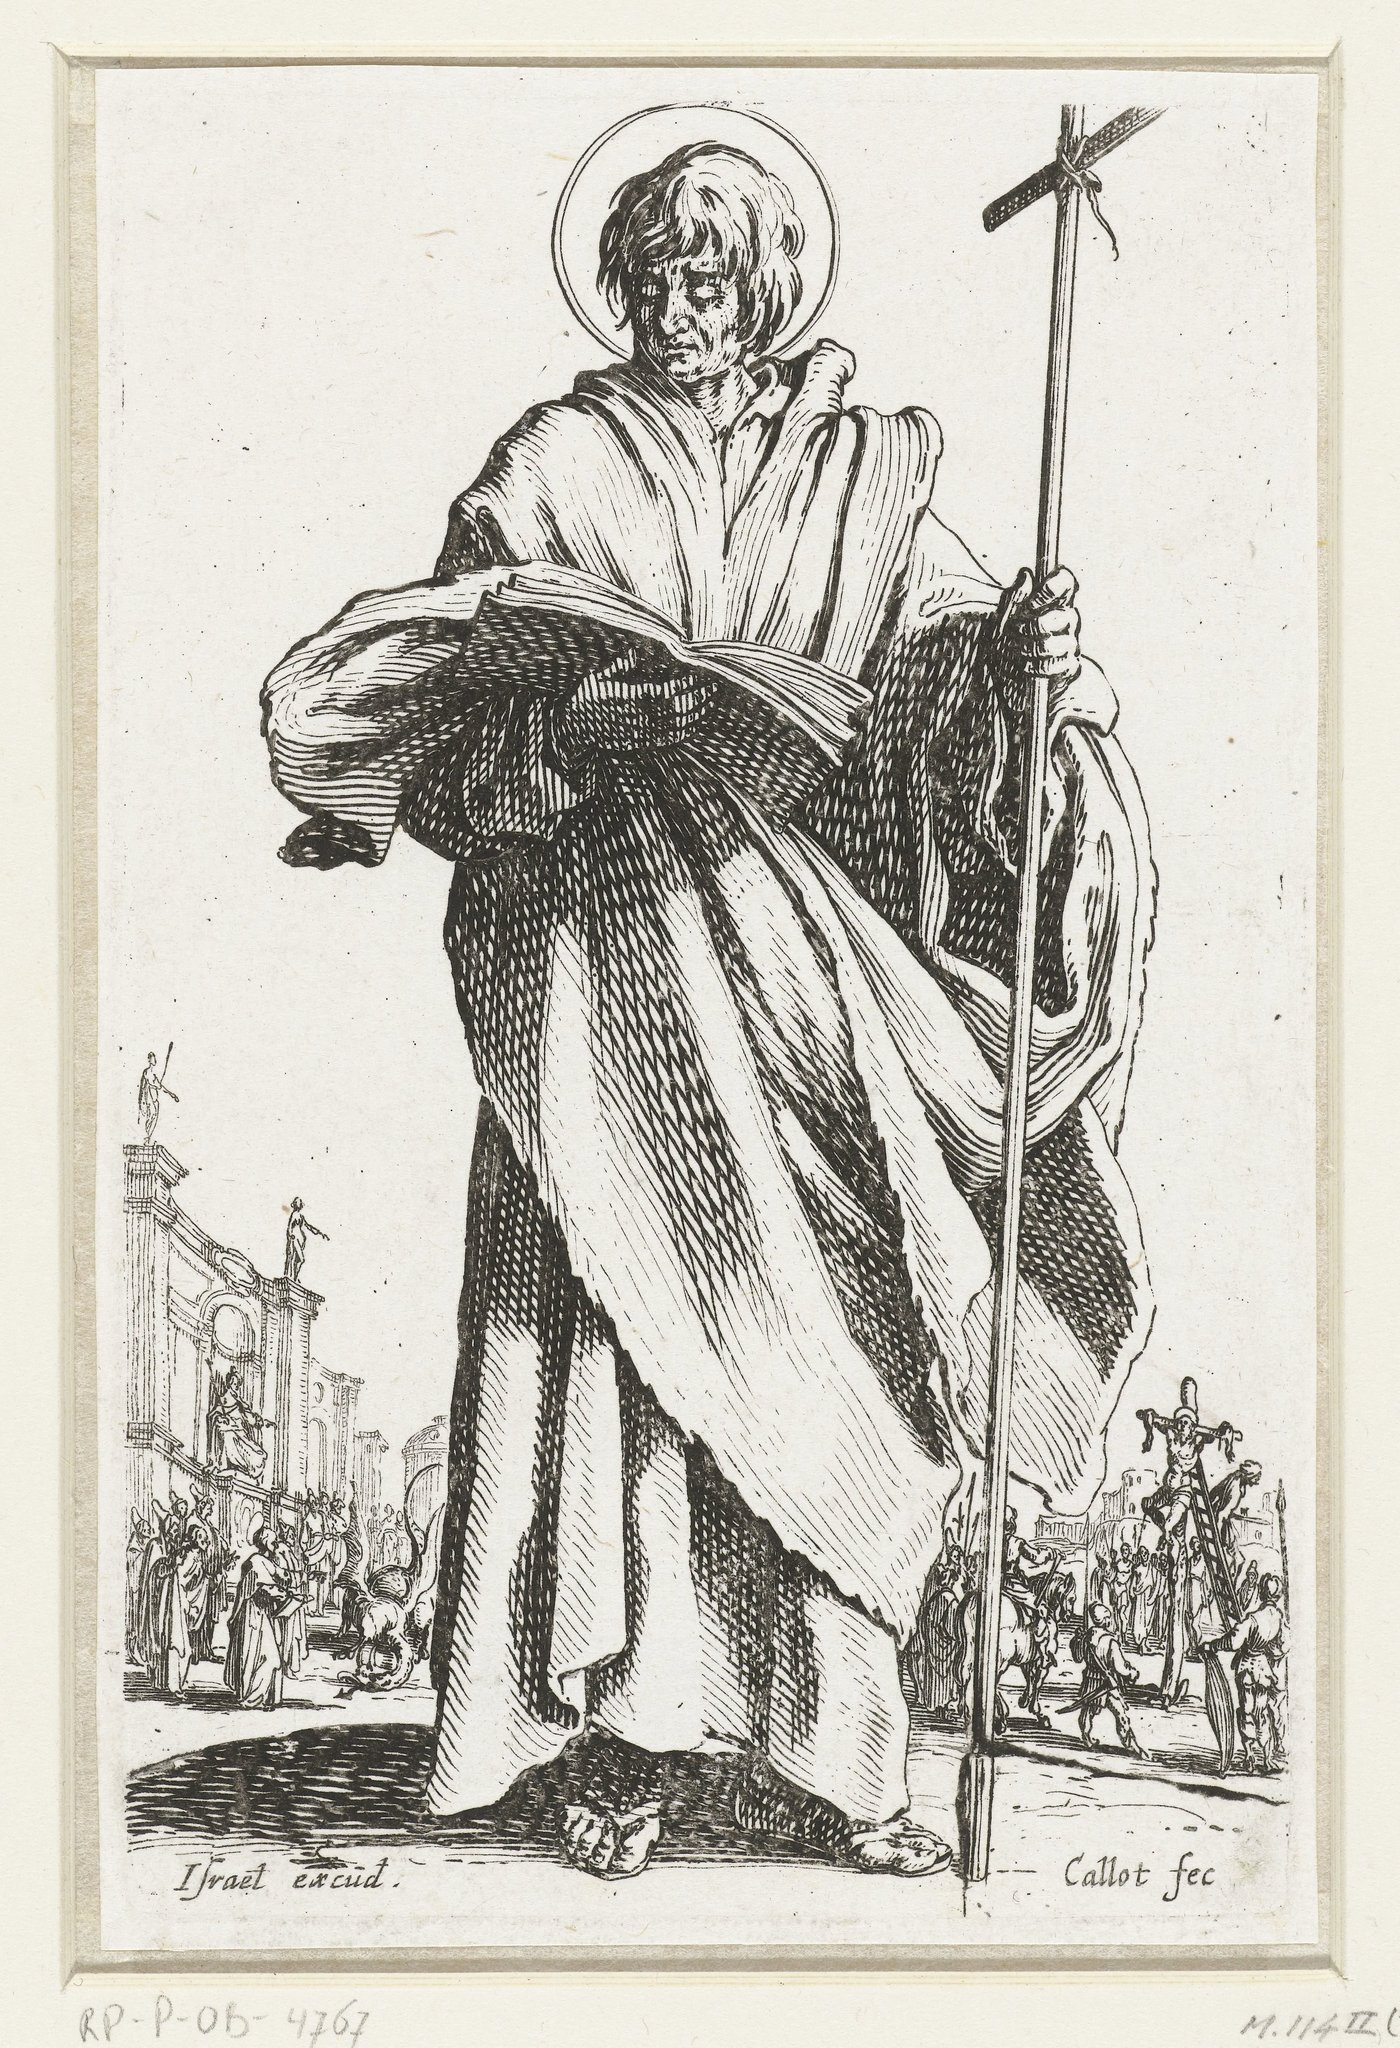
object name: print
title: De grote apostelen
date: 1631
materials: paper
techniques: etching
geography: nancy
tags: the apostle philip; possible attributes: book, cross, dish with snake, lance, scroll, stone, sword, philip is crucified (sometimes upside down), story of the banishment of a dragon out of the temple of mars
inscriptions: collector's mark: Lugt 240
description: Filippus, ten voeten uit, een staf in de ene hand en een boek in de andere hand. Op de achtergrond links is te zien hoe Filippus een draak uitdrijft; op de achtergrond rechts is te zien hoe hij wordt gekruisigd. Deze prent is onderdeel van een reeks van 16 prenten, bestaande uit een titelblad en 15 portretten, voorstellende Christus, Maria en de apostelen.